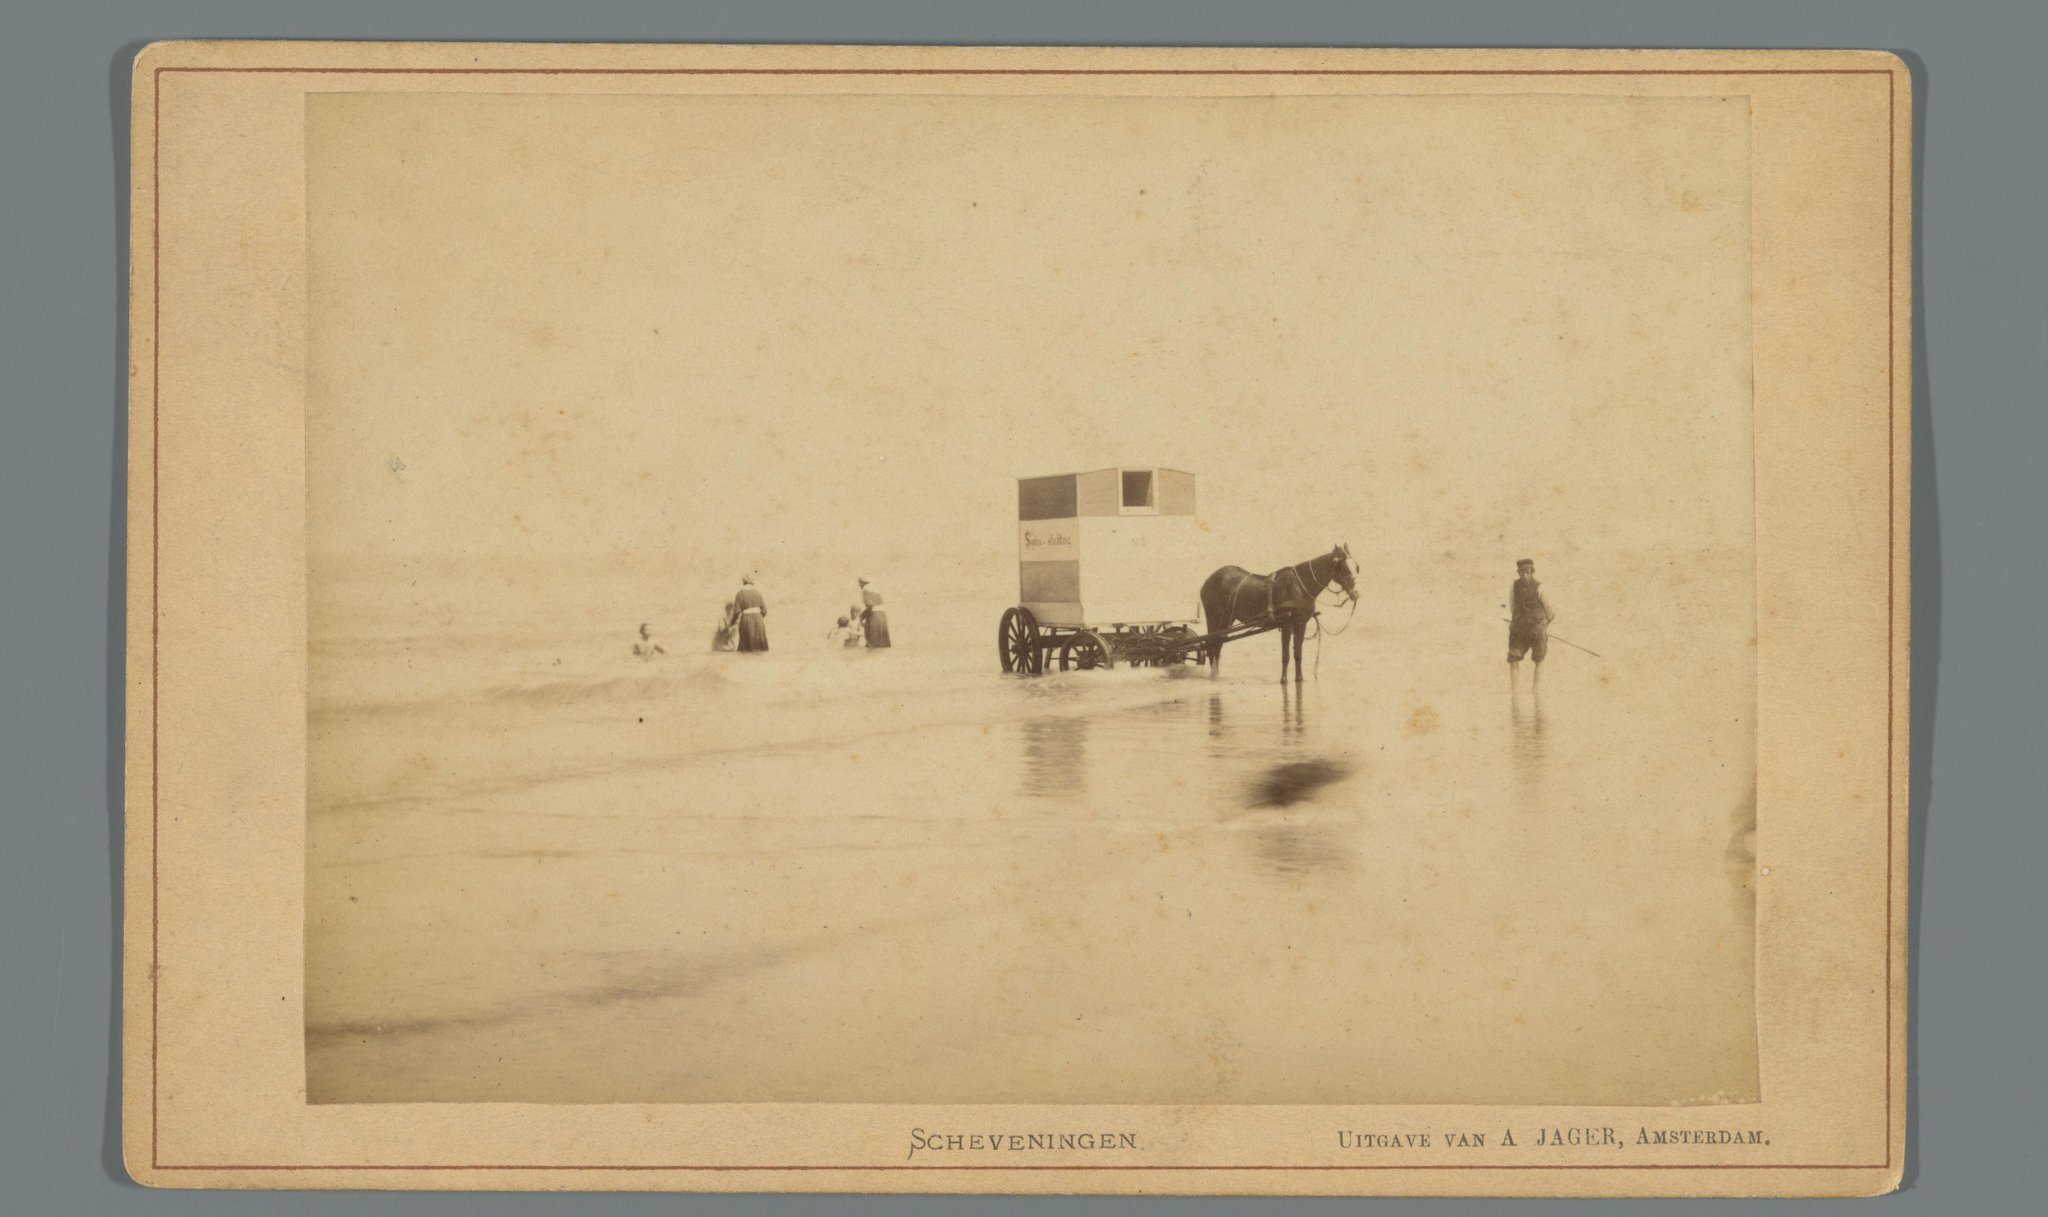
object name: photograph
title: Gezicht op het strand van Scheveningen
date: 1860-1890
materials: cardboard, photographic support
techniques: albumen print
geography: scheveningen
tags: ships, boats on land, beached